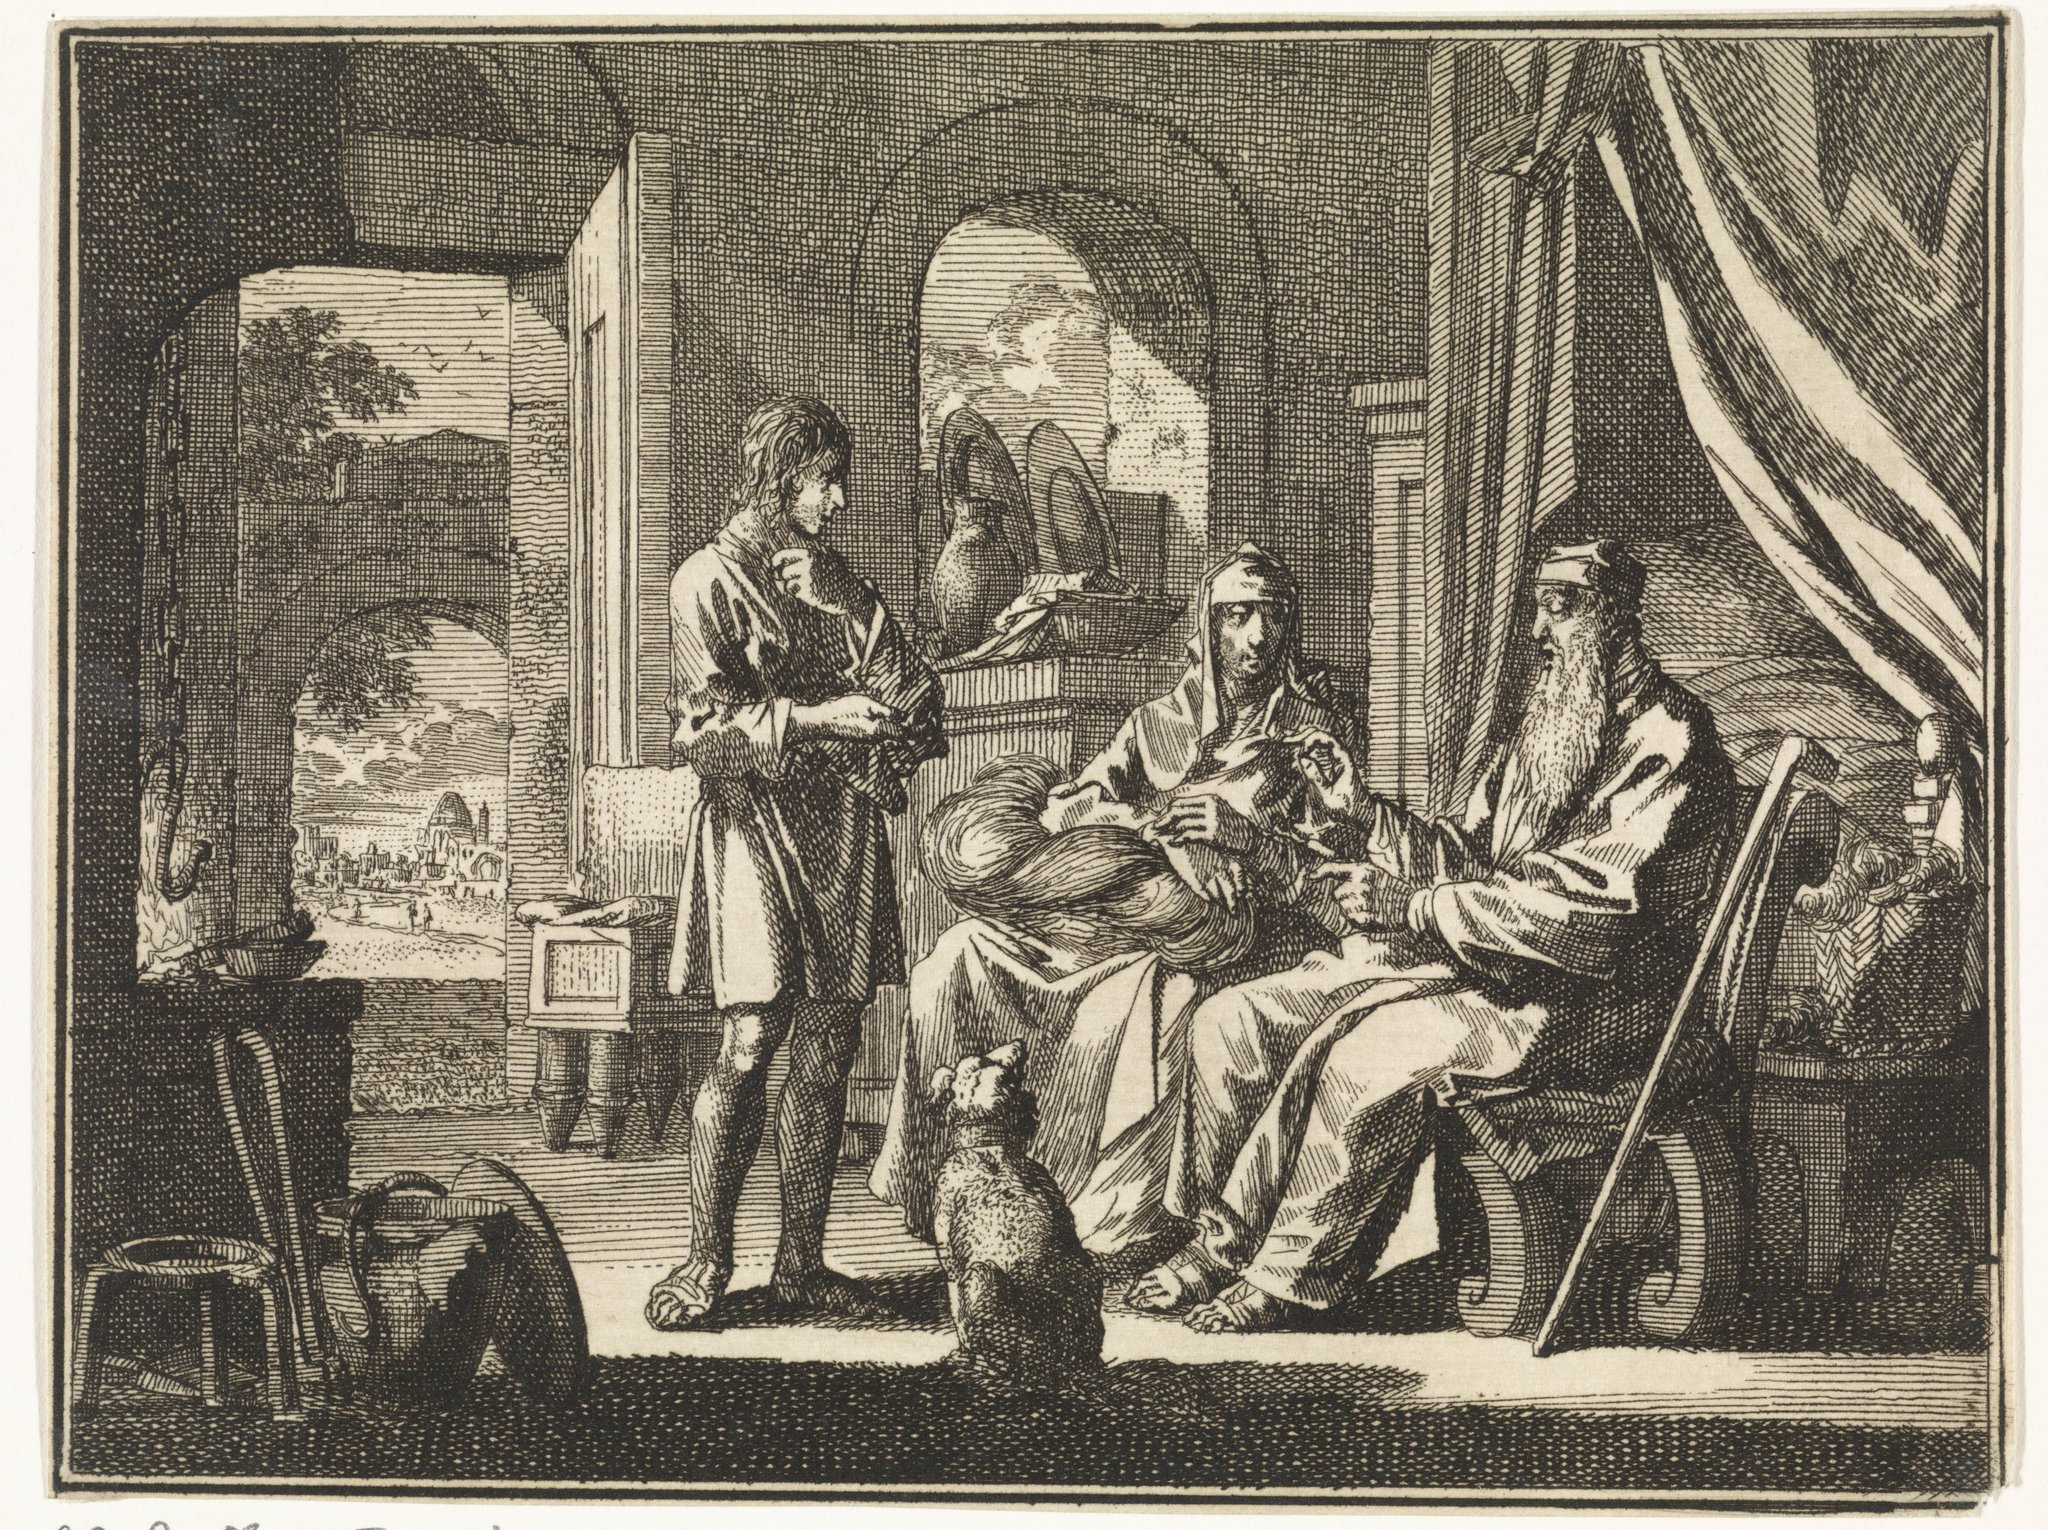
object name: print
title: De oude Tobias vermaant zijn zoon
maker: jan luyken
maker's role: draughtsman, print maker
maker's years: 1649-1712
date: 1712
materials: paper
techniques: etching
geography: amsterdam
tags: tobit and anna with their son tobias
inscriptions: number: ‘177’, collector's mark: Lugt 2228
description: Illustratie uit: Luyken, Jan. De schriftuurlyke geschiedenissen en gelykenissen van het Oude en Nieuwe Verbond, 2 delen. Amsterdam: Wed. Pieter Arentsz II en Cornelis van der Sys, 1712, dl. I.